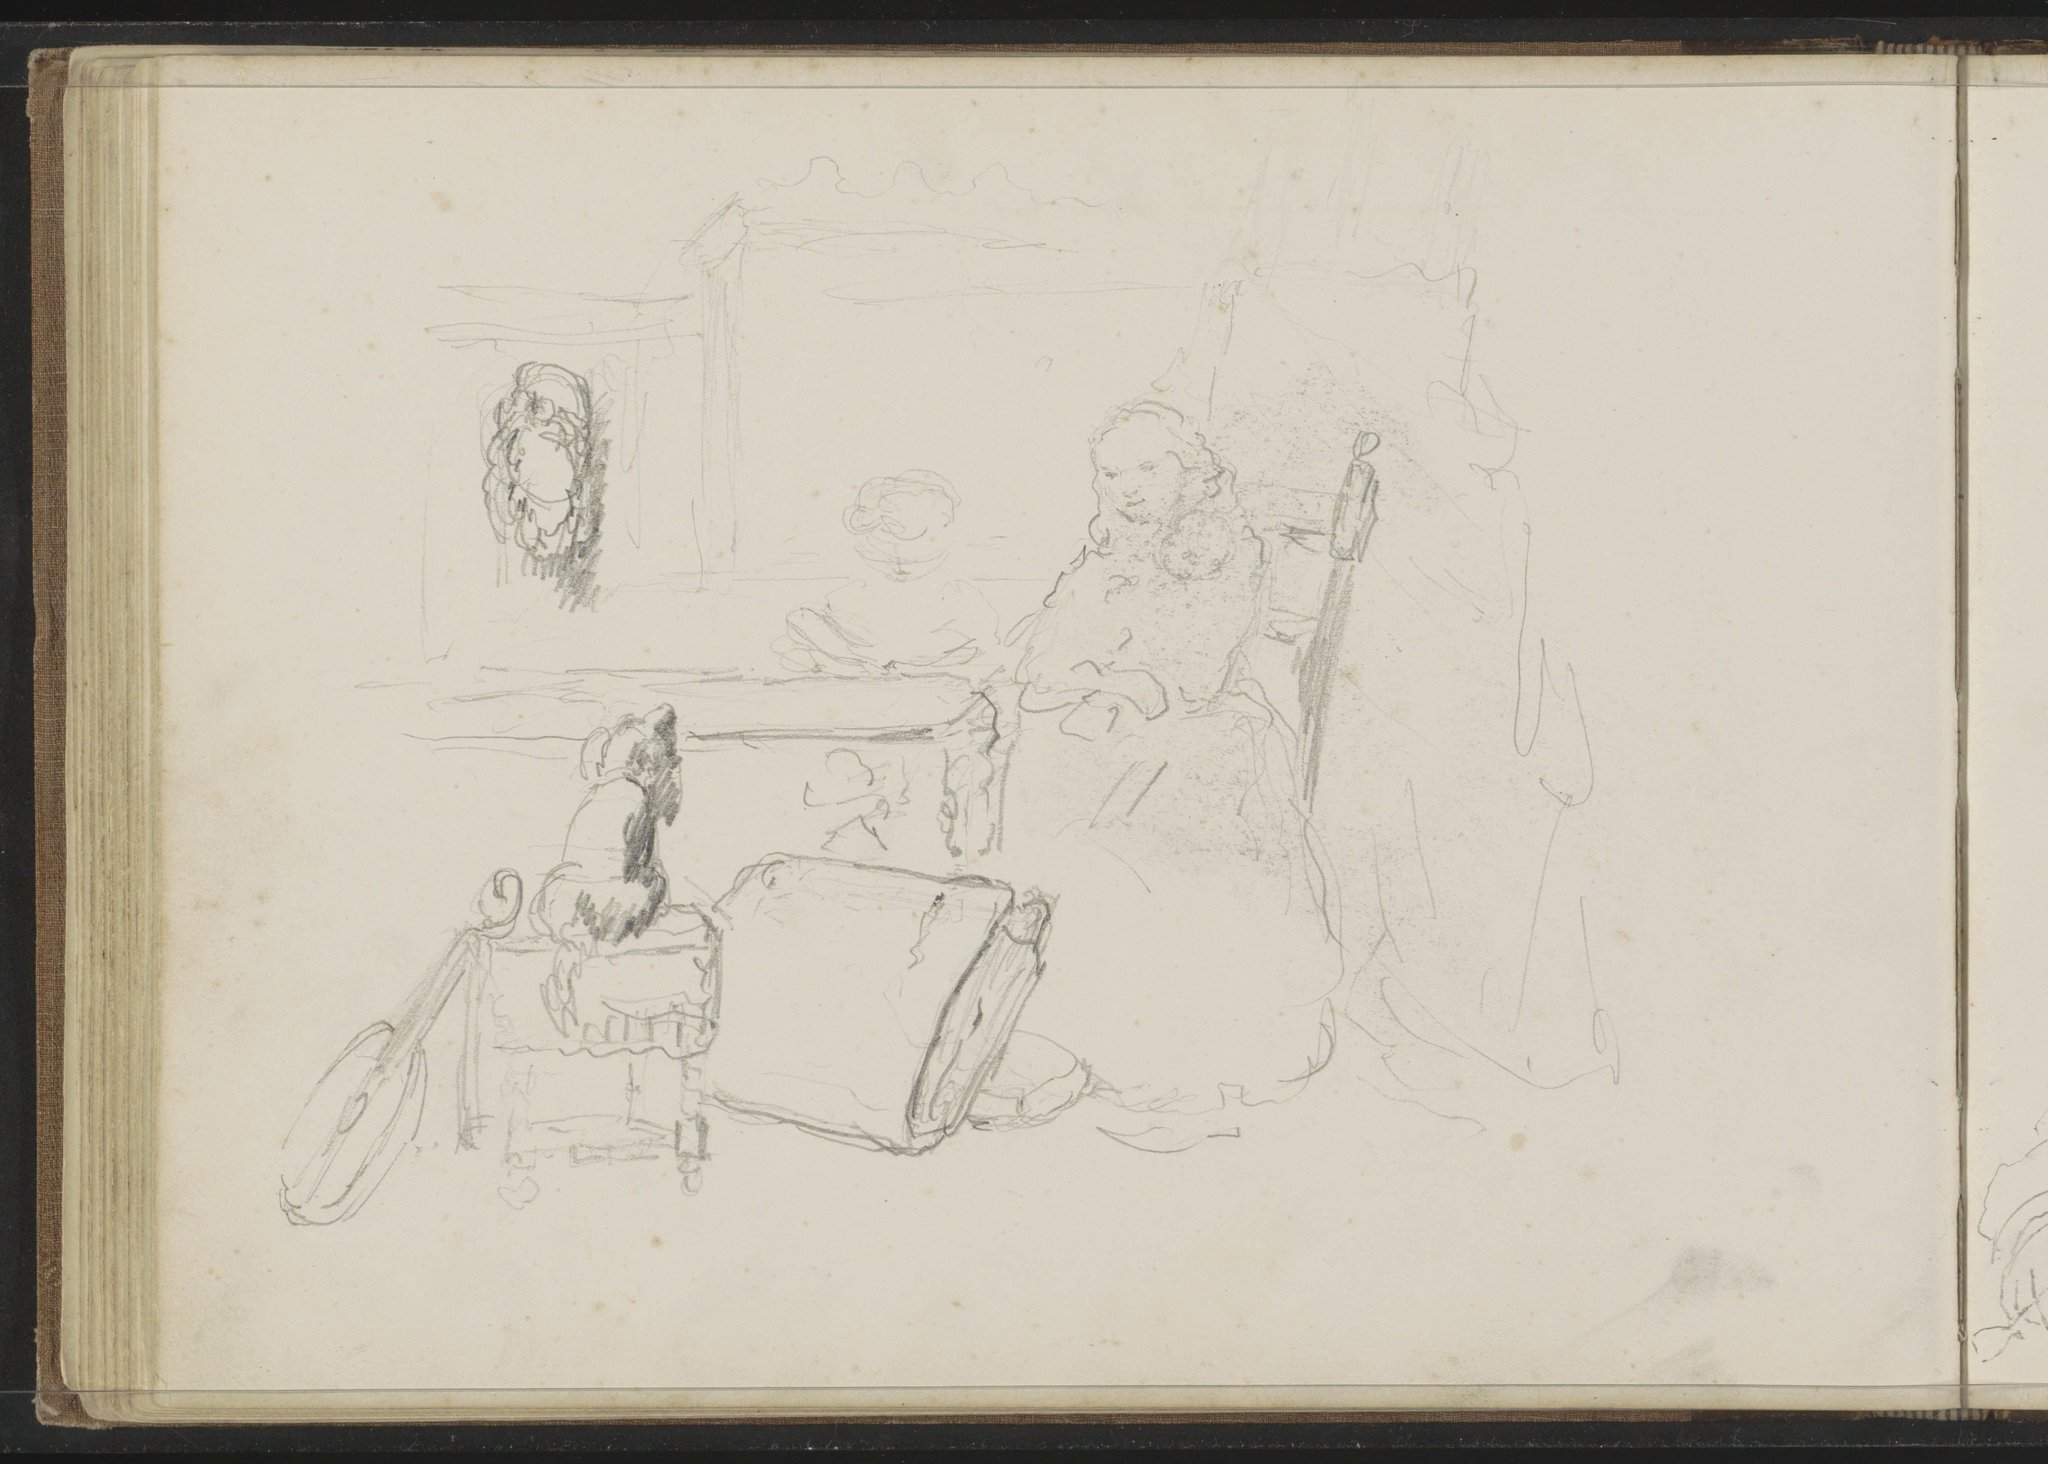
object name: sketchbook leaf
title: Vrouw en kind aan een tafel in een interieur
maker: hendrik valkenburg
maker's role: draughtsman, painter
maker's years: 1826-1896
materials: paper, pencil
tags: interior of the house, mother and baby or young child, lute, and special forms of lute, e.g.: theorbo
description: In het interieur staan een boek en luit en zit een hond op een kruk. Blad 58 verso uit een schetsboek met 77 bladen.